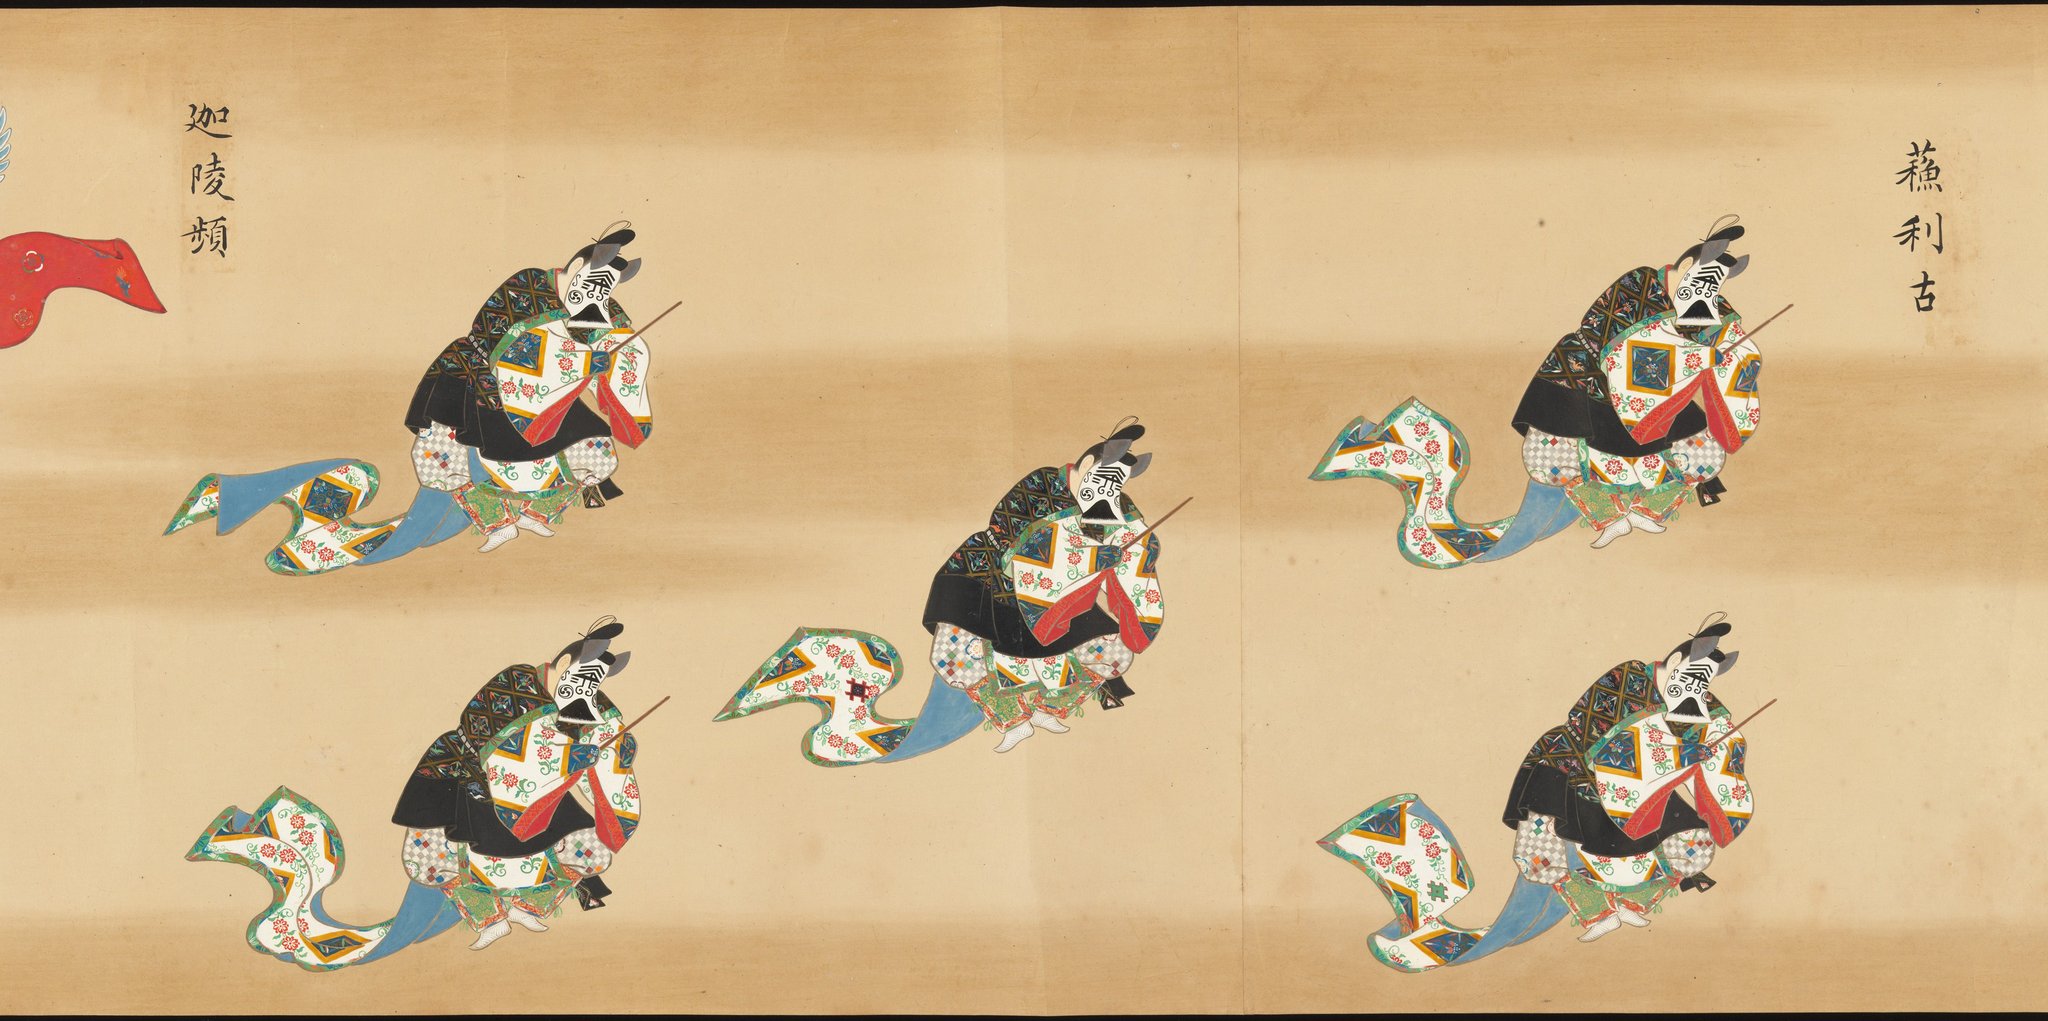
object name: handscroll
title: Bugaku Imperial Court Dance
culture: japanese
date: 1601-1700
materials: gold, ink, paper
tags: dancing,dancers